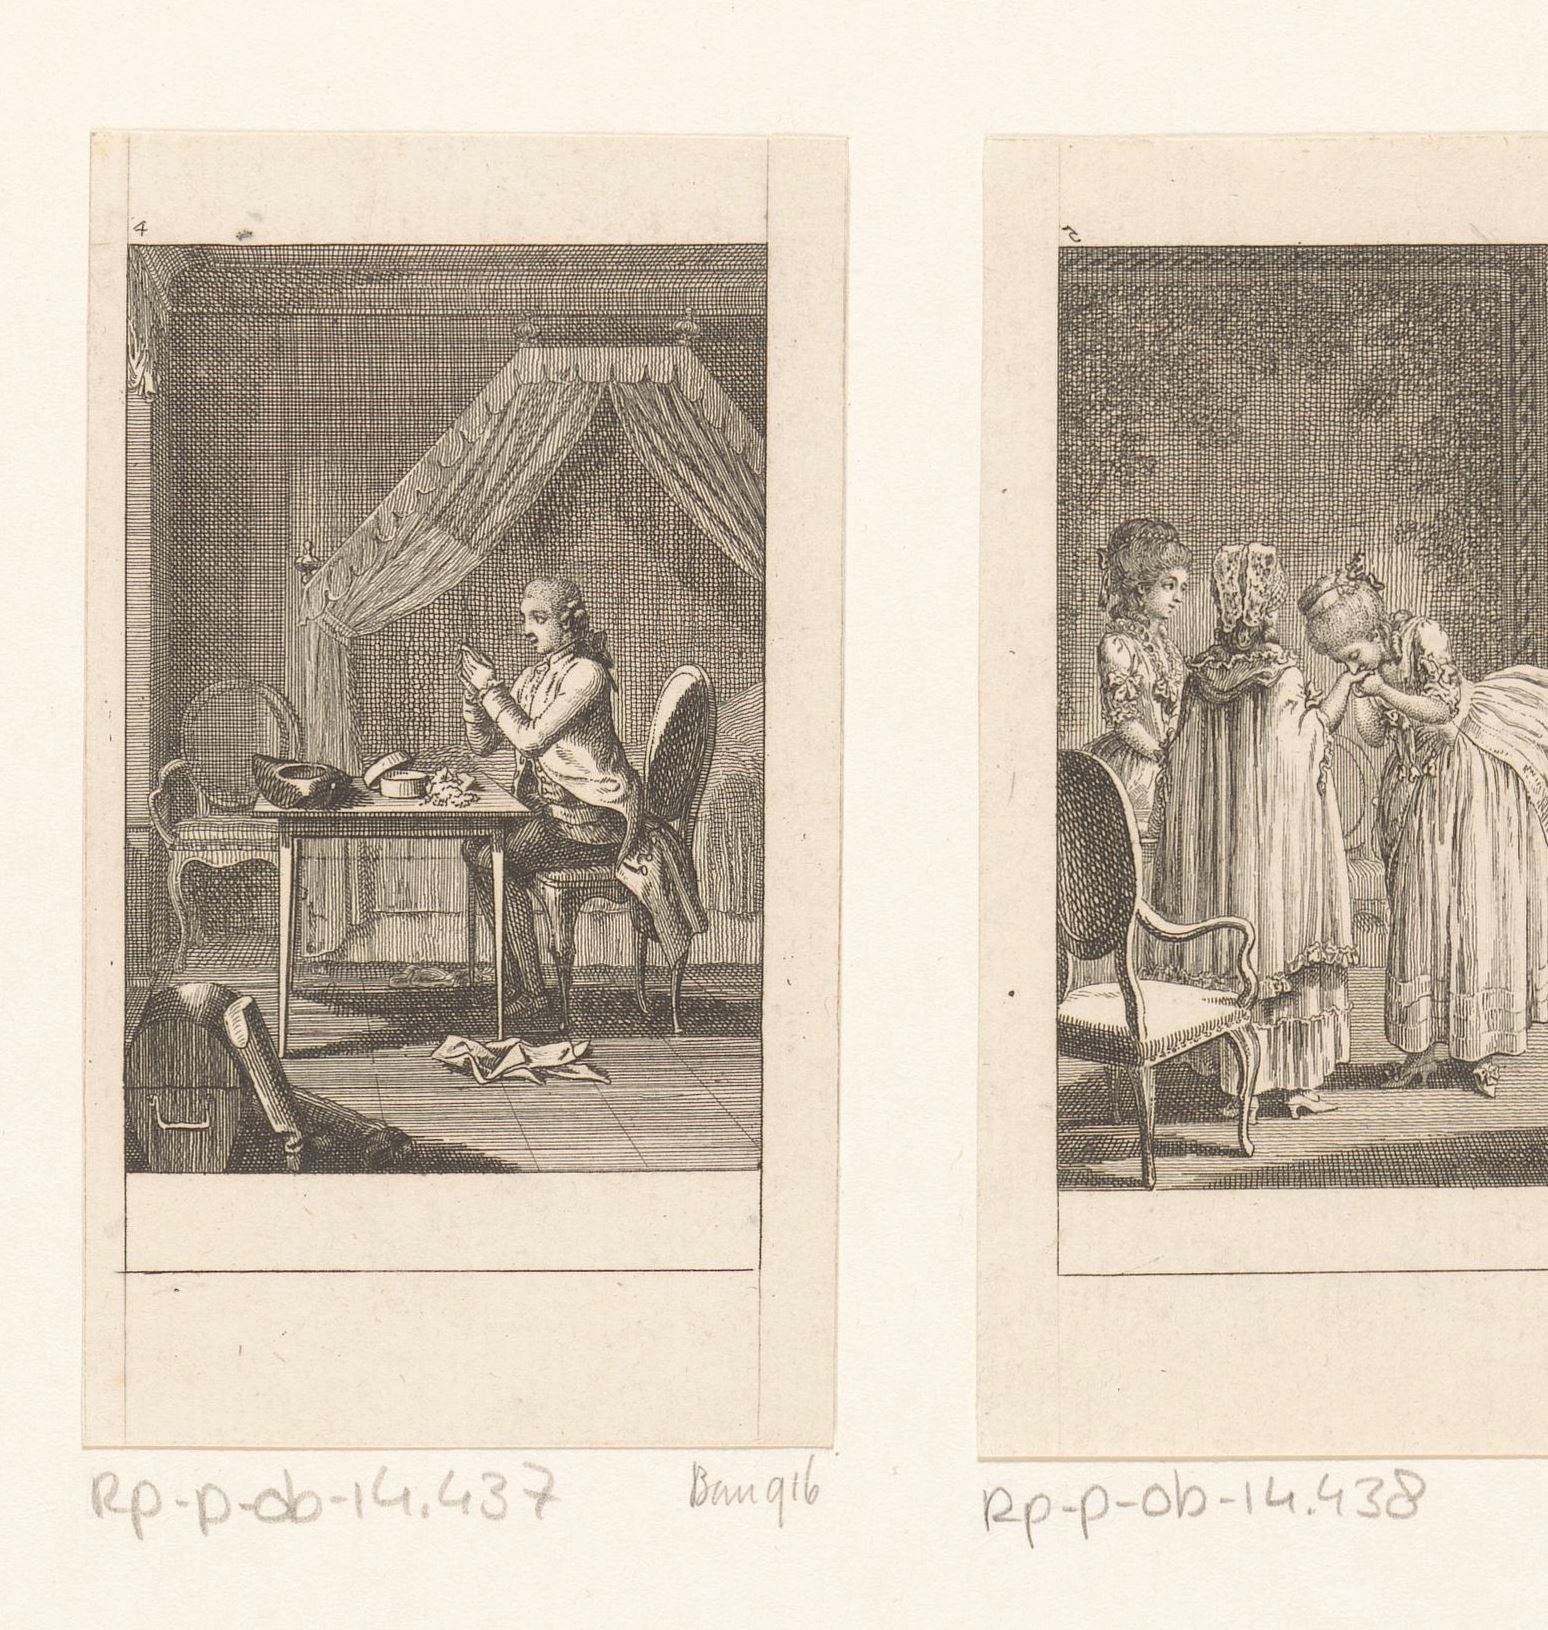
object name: print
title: St. Preux ontvangt Julies talisman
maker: daniel nikolaus chodowiecki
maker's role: draughtsman, print maker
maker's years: 1726-1801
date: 1782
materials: paper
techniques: etching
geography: berlin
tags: amulet, talisman, delivering; receiving (~ postal matter), interior of the house, parcel, packet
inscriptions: collector's mark: Lugt 2228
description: Vervaardigd voor Jean-Jacques Rousseaus 'Neue Héliose'. Latere staat gebruikt voor: Almanac généalogique pour l'année 1783. Berlijn: s.n., 1782.